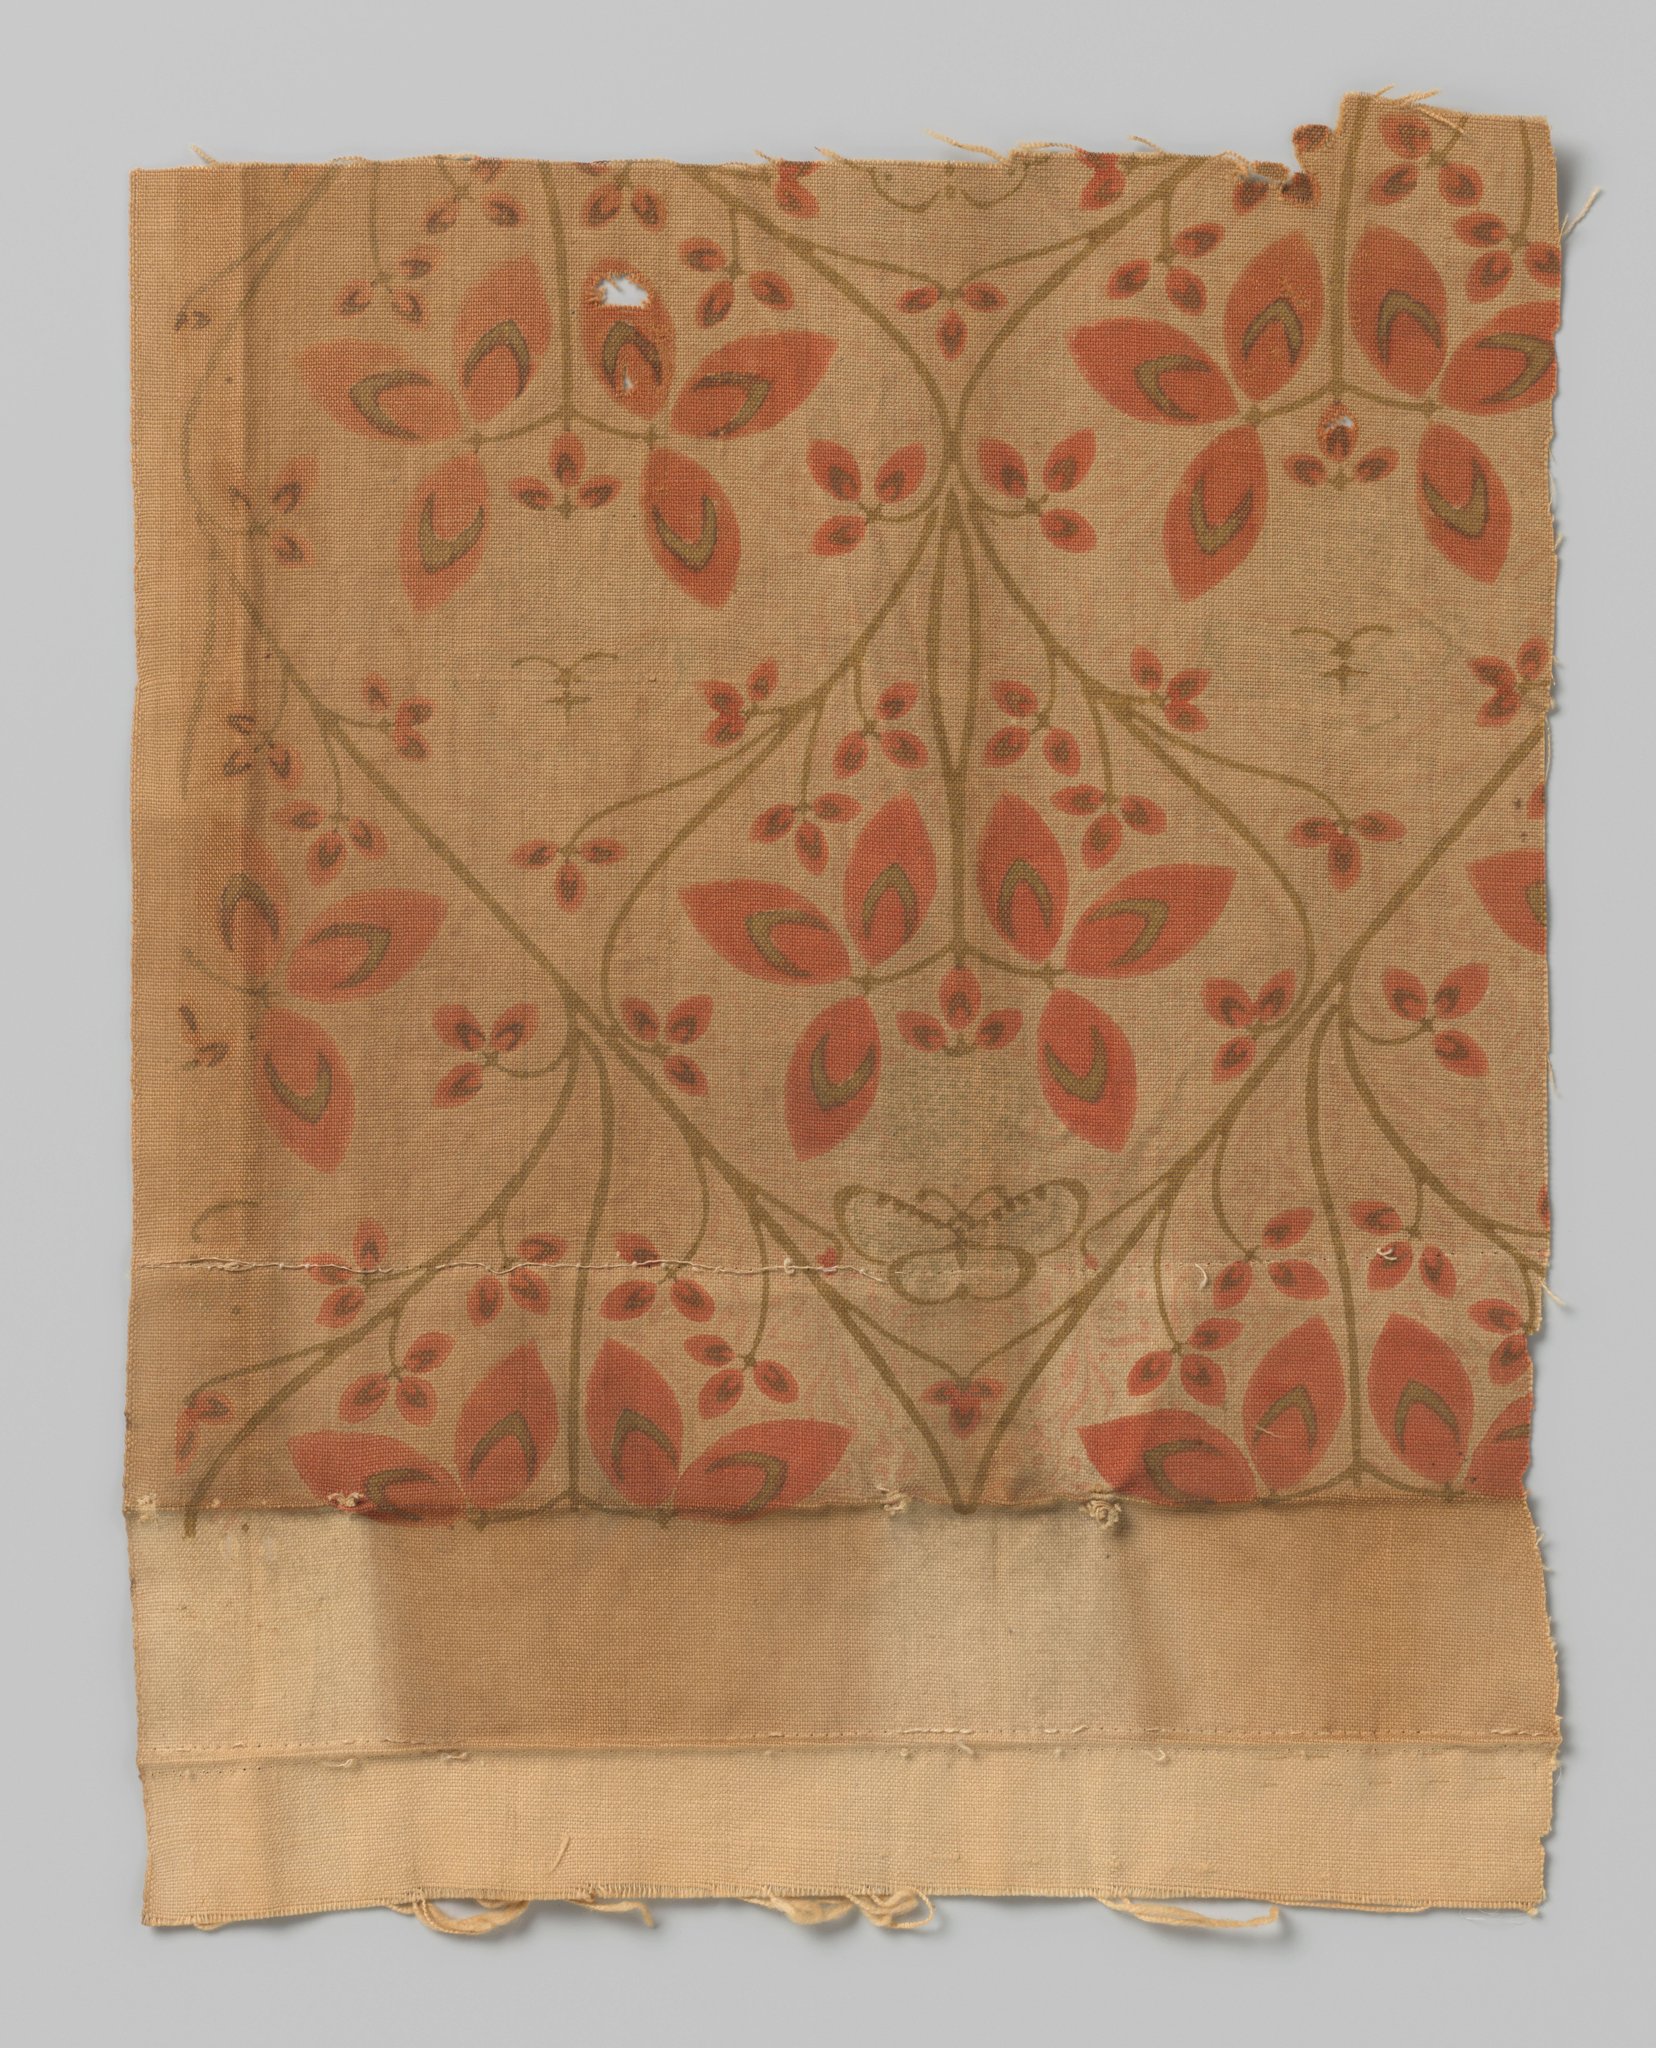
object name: upholstery fabric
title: Fragment bedrukte cretonne met patroon van klaver met vlinder binnen spitsovalen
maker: theo nieuwenhuis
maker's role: designer, draughtsman, print maker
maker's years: 1866-1951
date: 1900-1925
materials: linen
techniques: printing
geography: netherlands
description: Fragment bedrukte cretonne met patroon van klaver met vlinder binnen spitsovalen in de kleuren rood, een vergane kleur, mosgroen en roze op naturel fond.